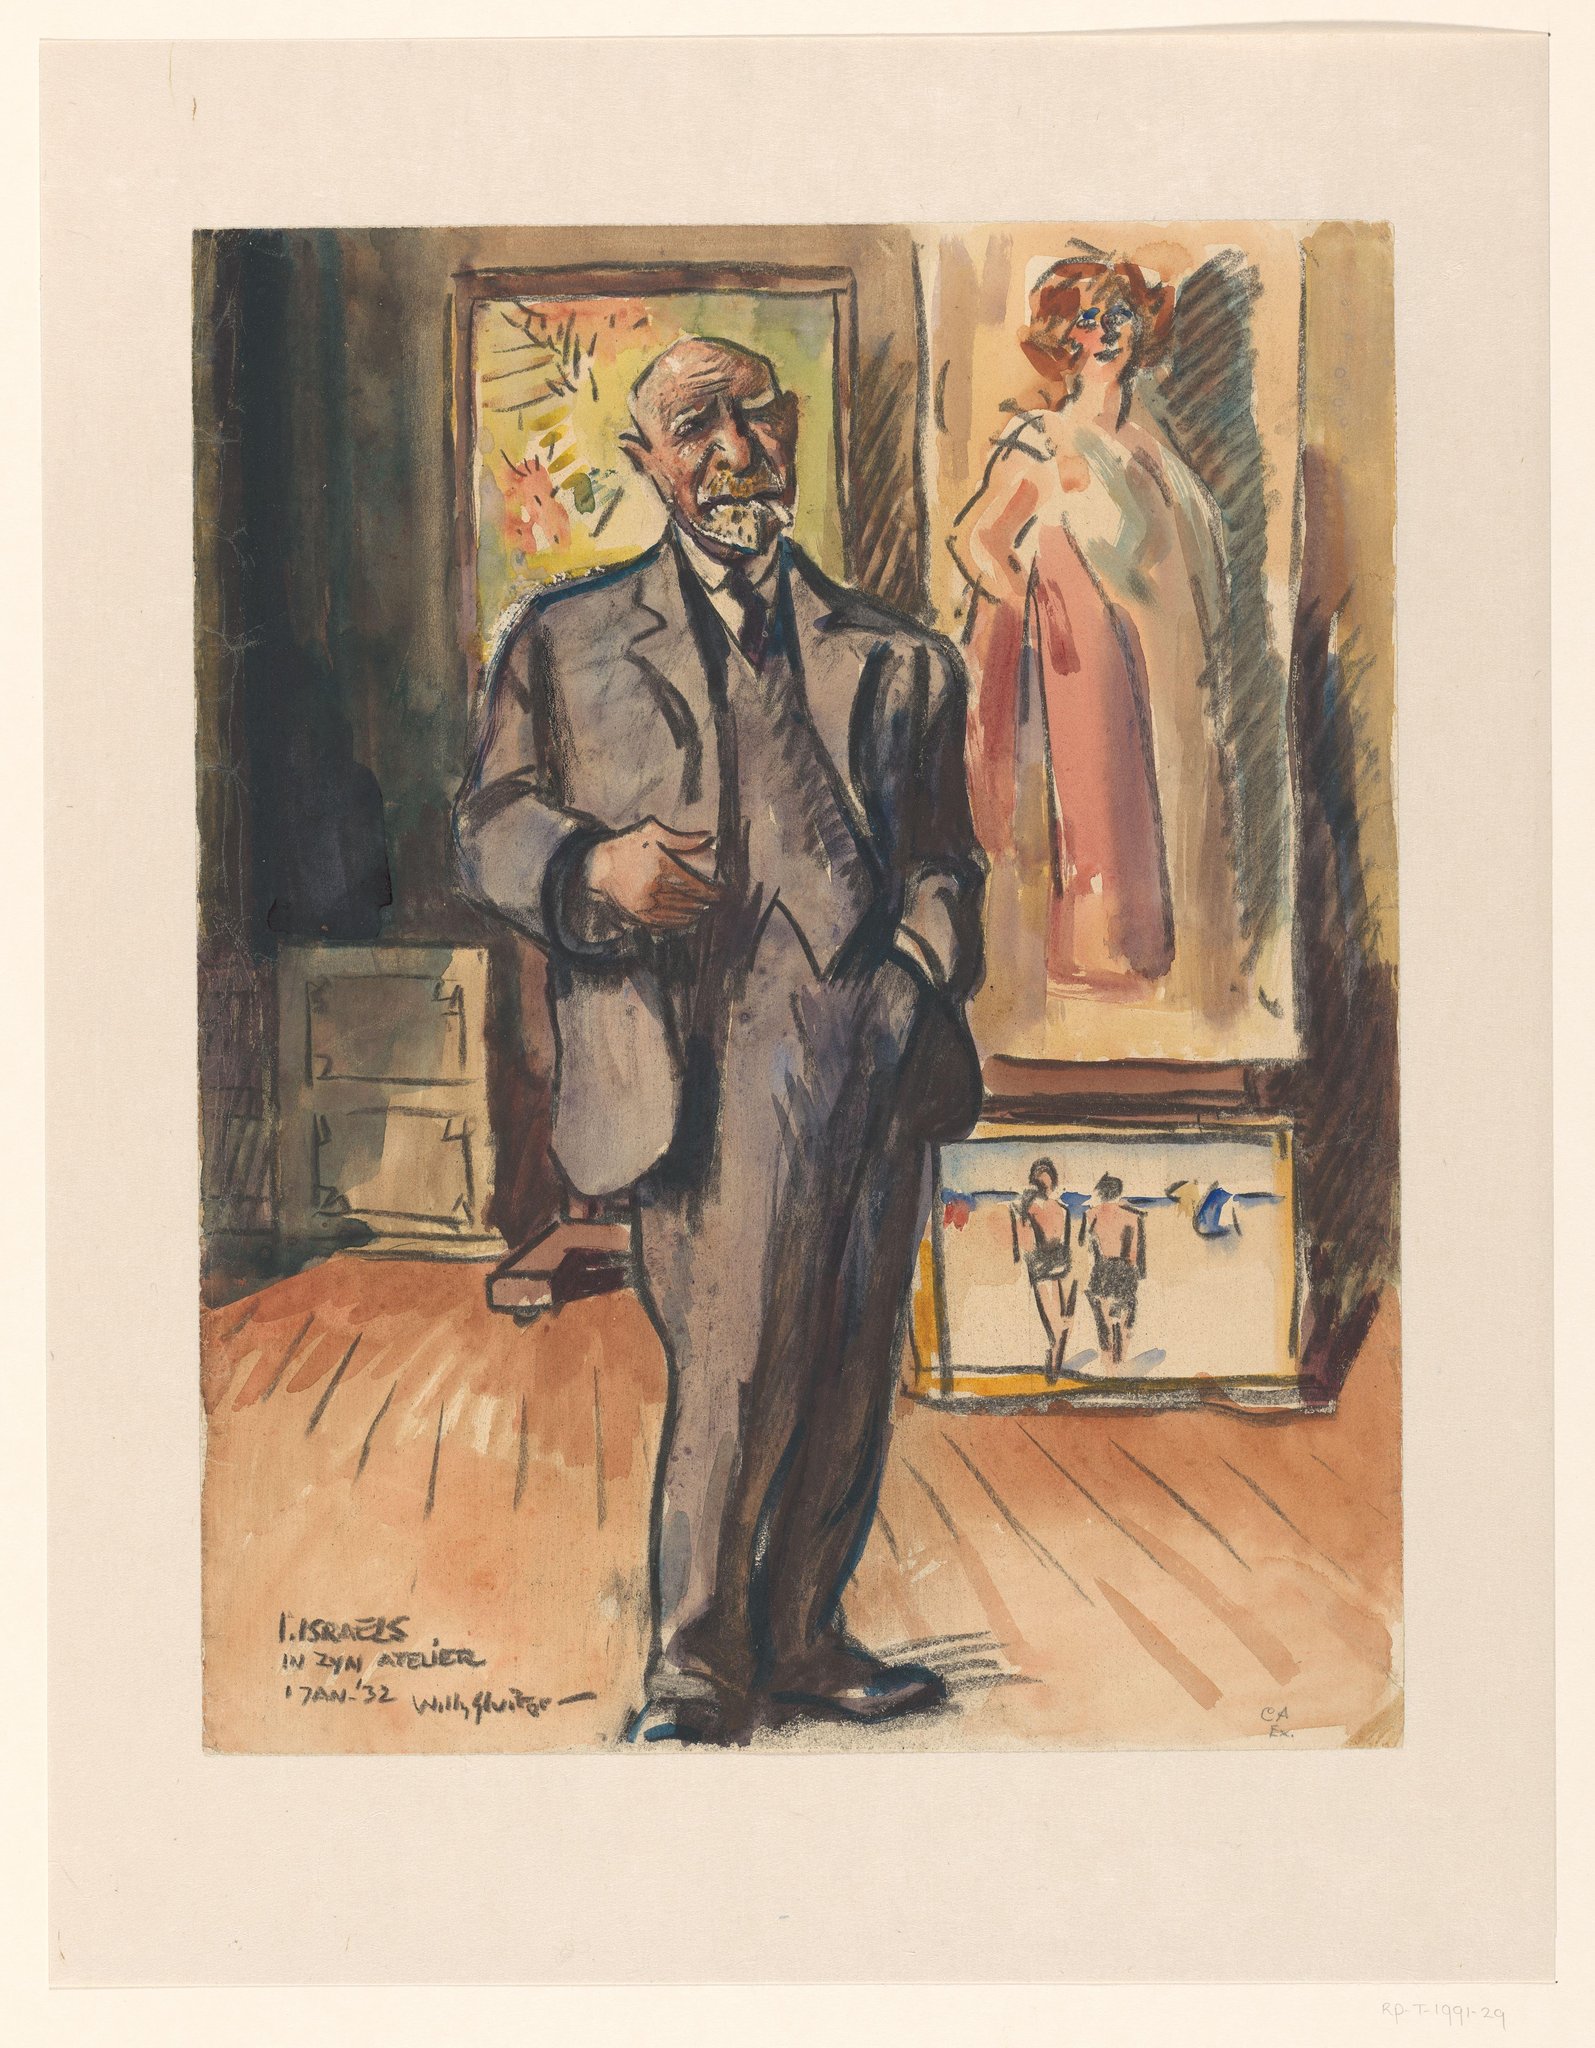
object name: drawing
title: I. Israels in zijn atelier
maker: willy sluiter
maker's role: draughtsman, painter, print maker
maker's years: 1873-1949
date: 1932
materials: charcoal, paper, watercolor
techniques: brush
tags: amsterdam, painter, draughtsman, isaac israels, historical persons, portrait, self-portrait of painter, portrait, self-portrait of artist, workshop, studio of the artist (in general)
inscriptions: inscription: ‘CA/ EX.’, collector's mark: Lugt 2228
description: Portret van Isaac Israels staand voor een aantal schilderijen.